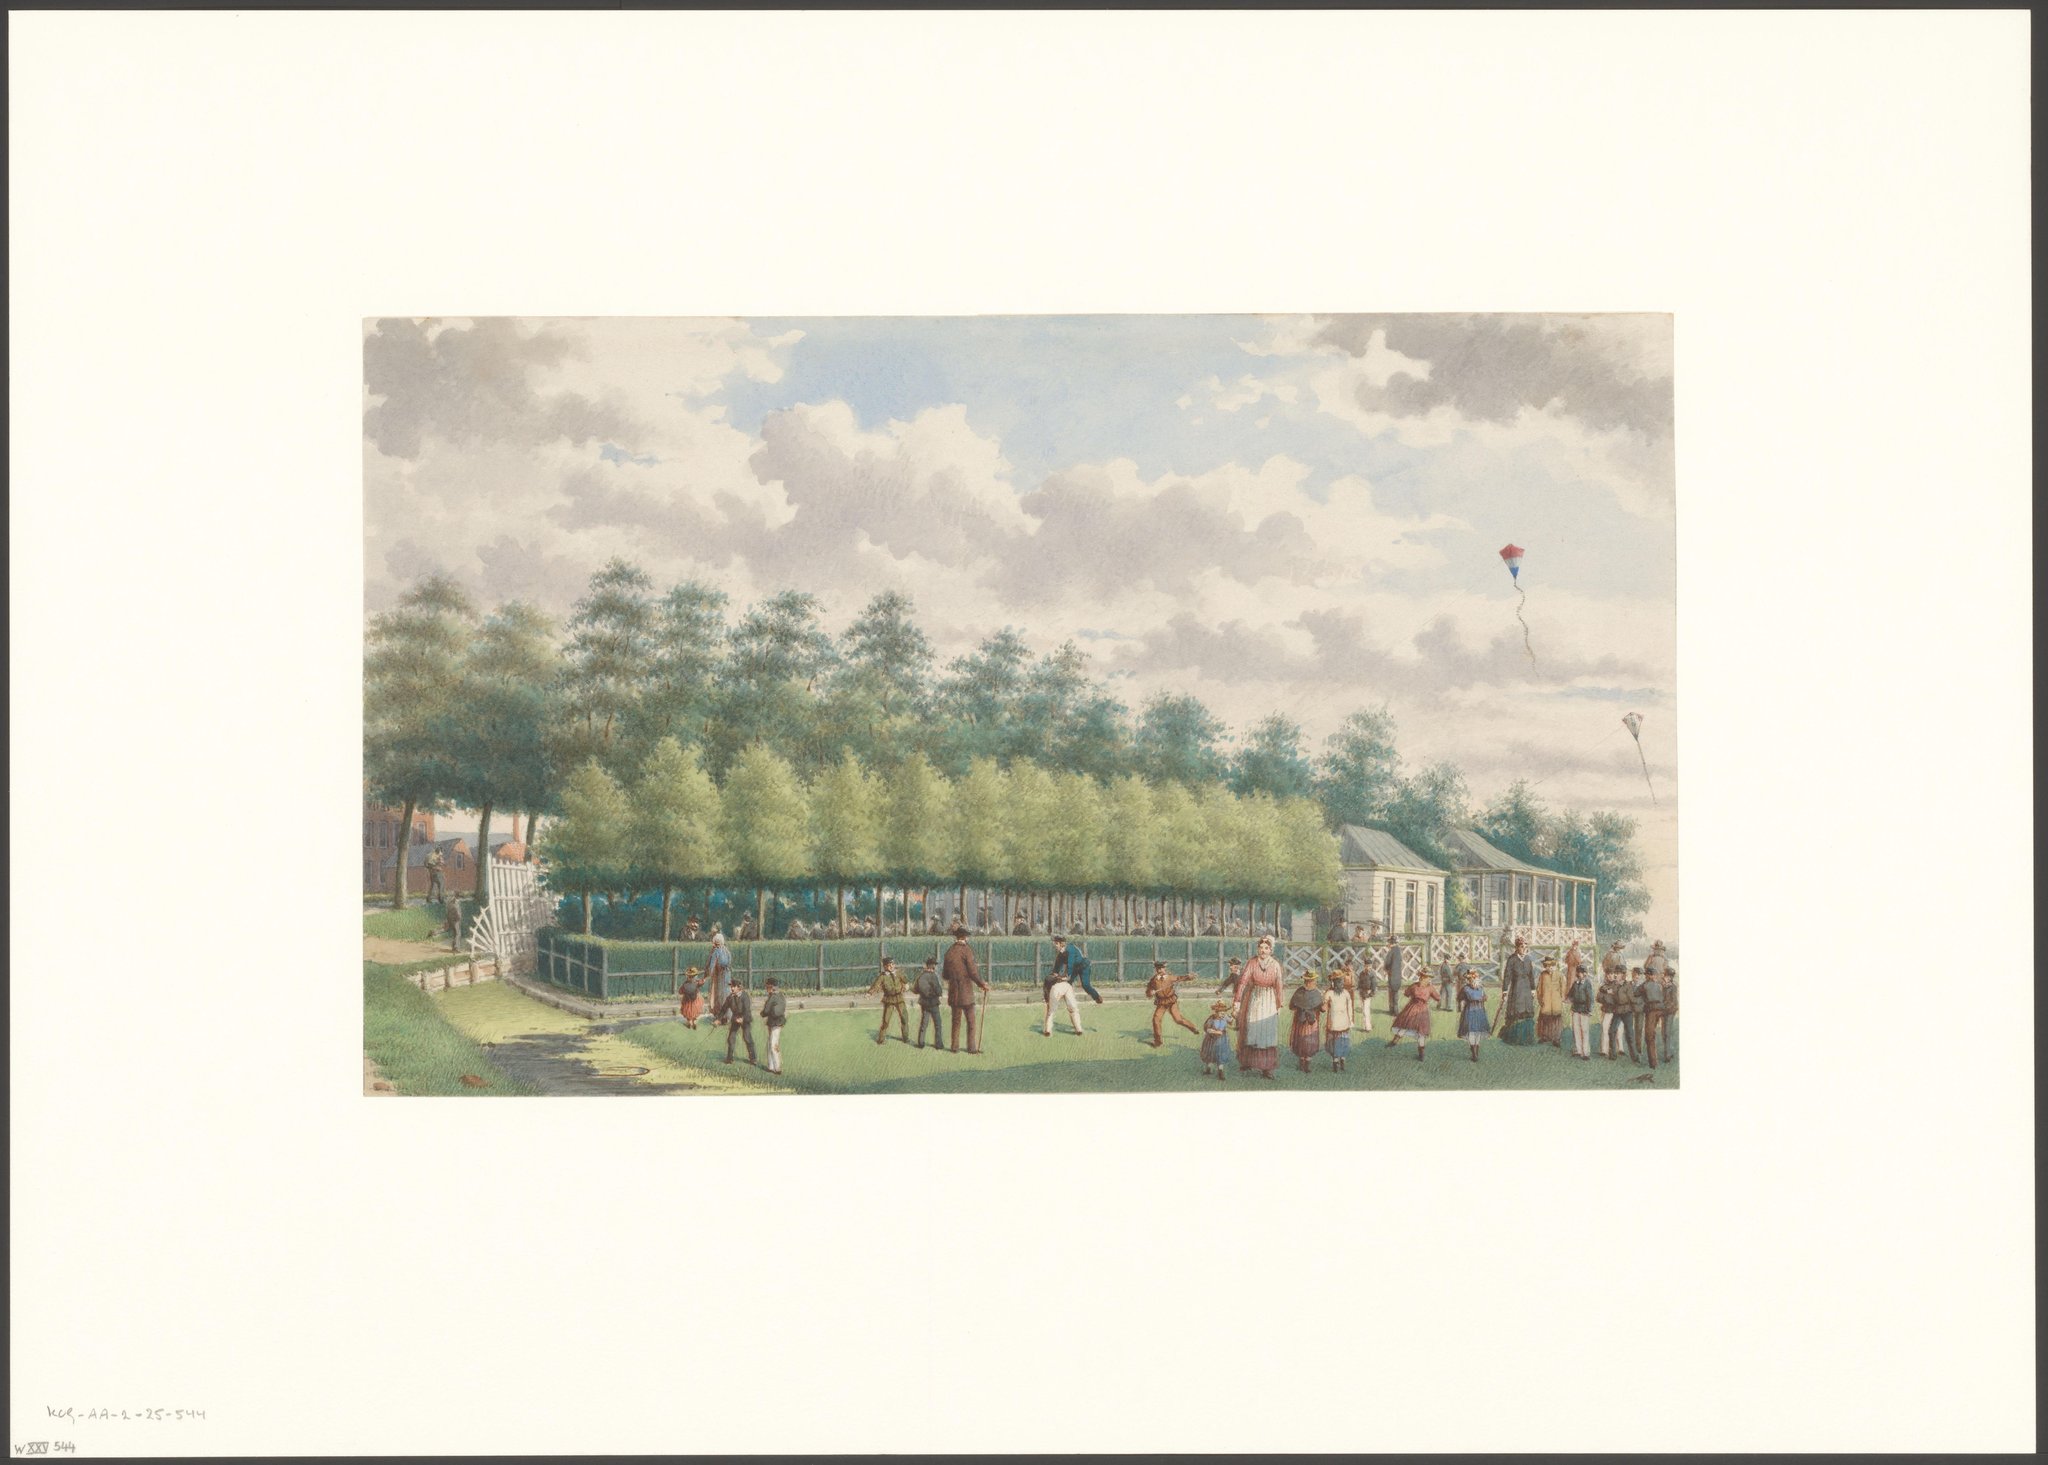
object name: drawing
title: Gezicht op het Oosterpark aan de Linnaeusstraat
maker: johan martinus anthon rieke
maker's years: 1851-1899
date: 1861-1899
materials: ink, paper, pencil, watercolor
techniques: brush, pen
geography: amsterdam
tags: city-view in general; 'veduta', open-air recreation, public gardens, park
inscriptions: collector's mark: Lugt 800a, stamp: ‘J. van Eck.’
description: Tekening binnen de Atlas Van Eck ingedeeld op wijknummer 25.